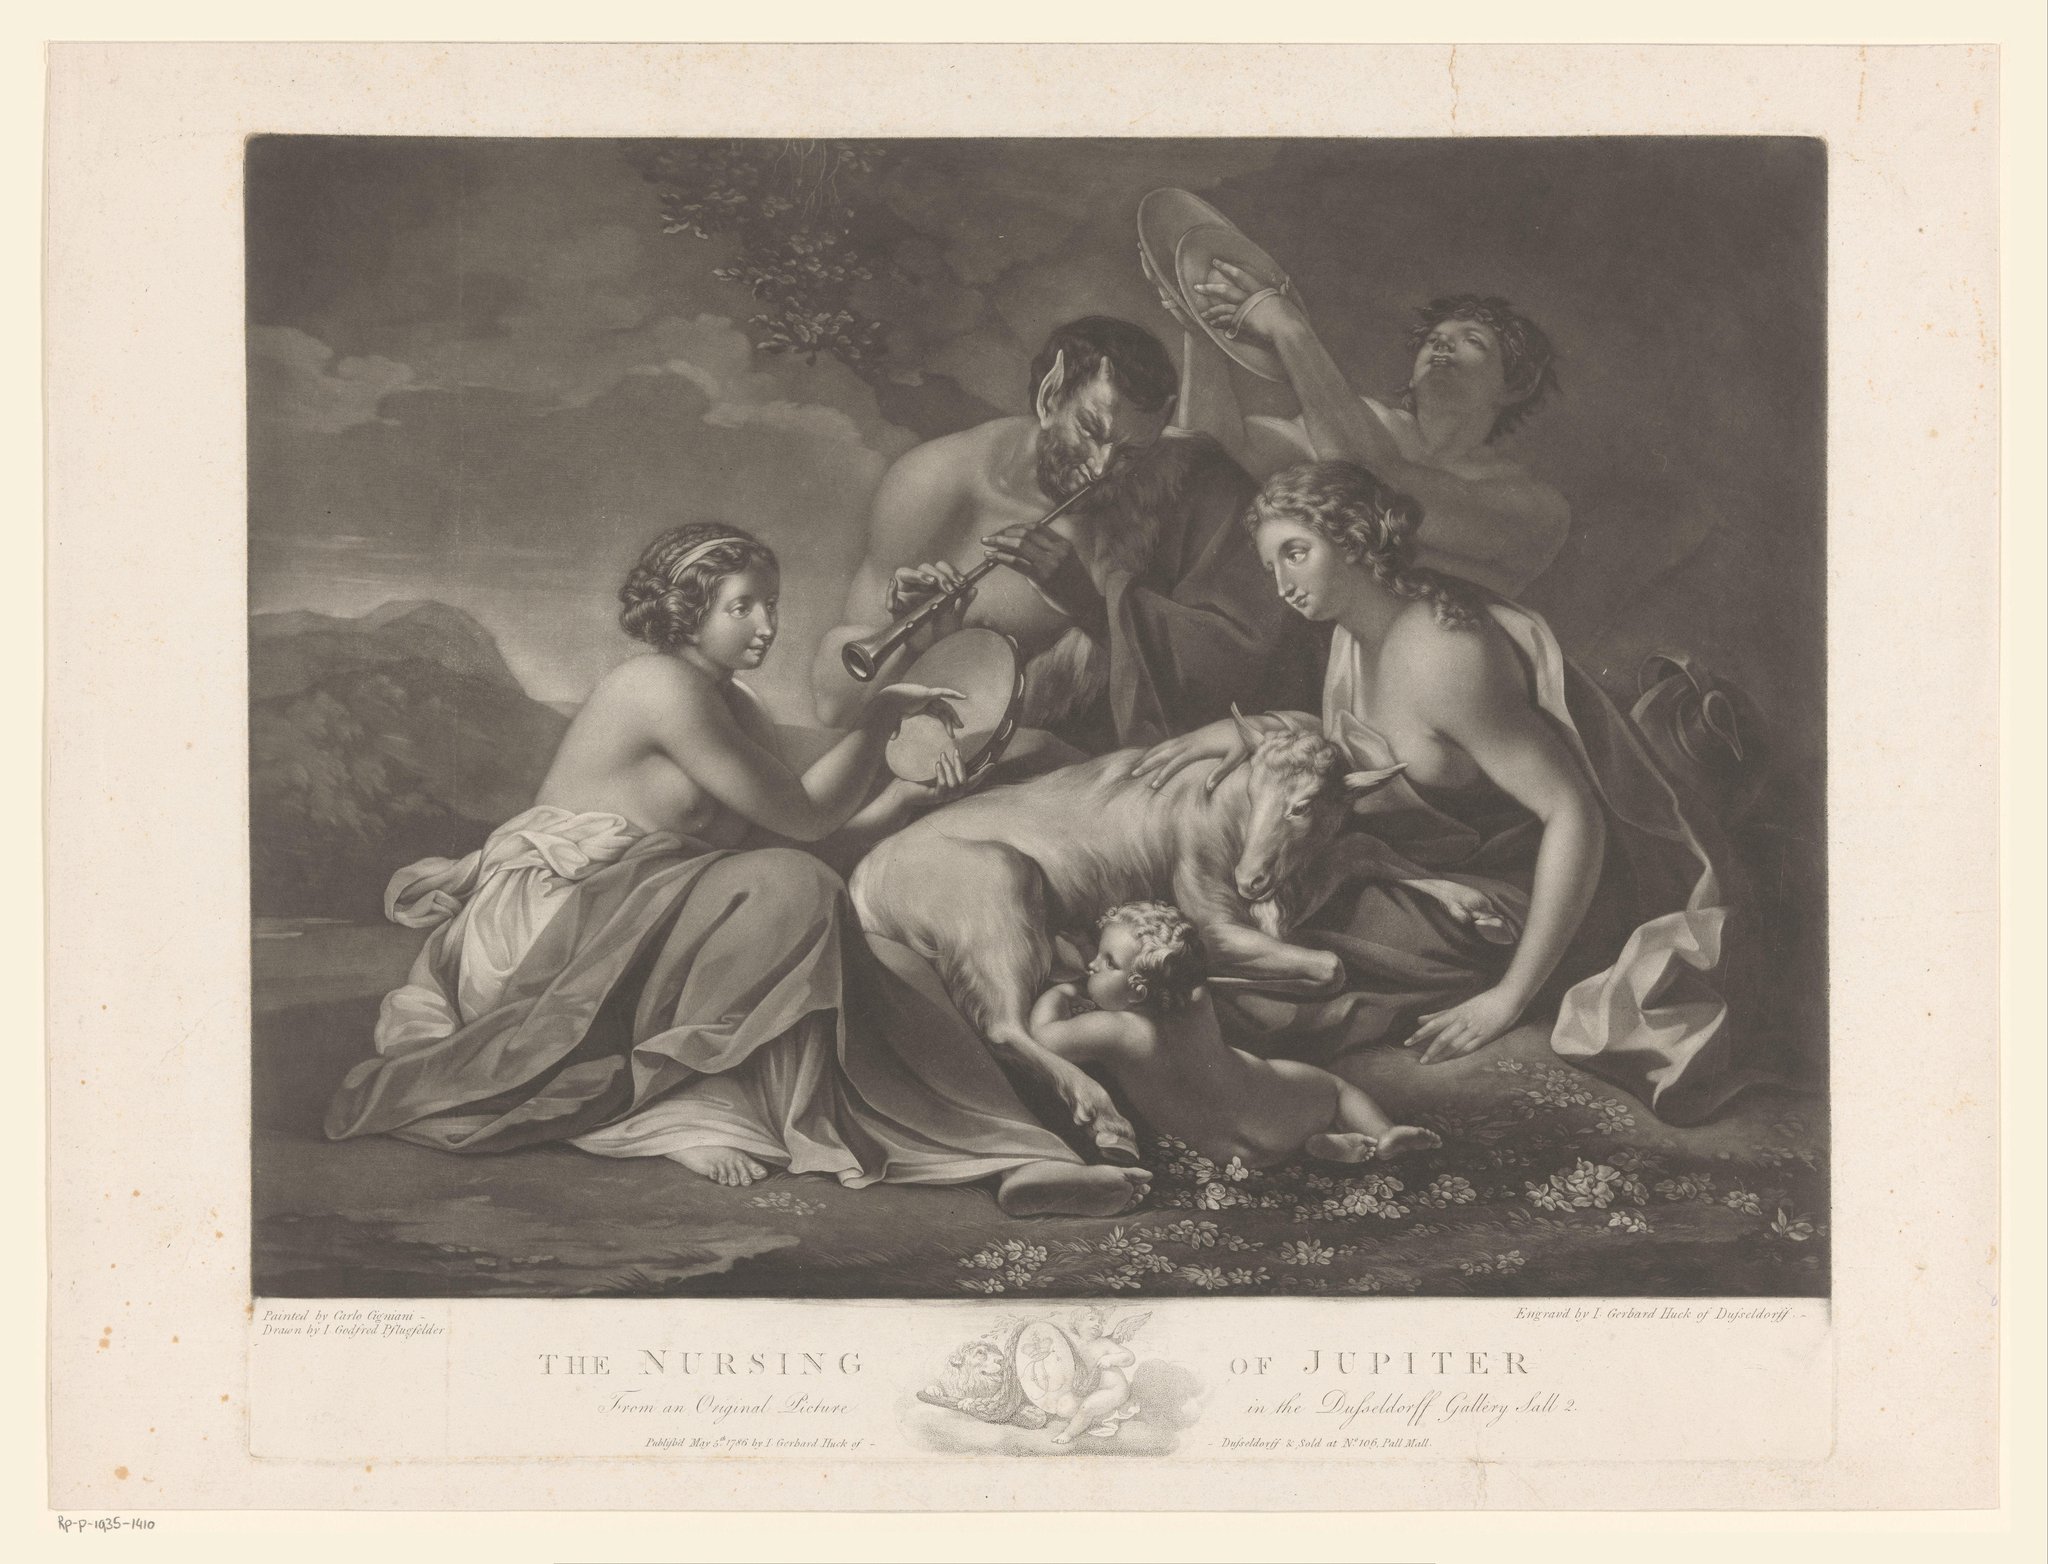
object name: print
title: The Nursing of Jupiter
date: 1786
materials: paper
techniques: mezzotint, stippling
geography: dusseldorf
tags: amalthea, the nymph, usually in the shape of a goat, suckles the new-born jupiter, armorial bearing, heraldry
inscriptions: collector's mark: Lugt 2760, collector's mark: Lugt 2166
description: Ten tijde van de vervaardiging van deze prent was het origineel te zien in zaal twee van de galerie in Düsseldorf.